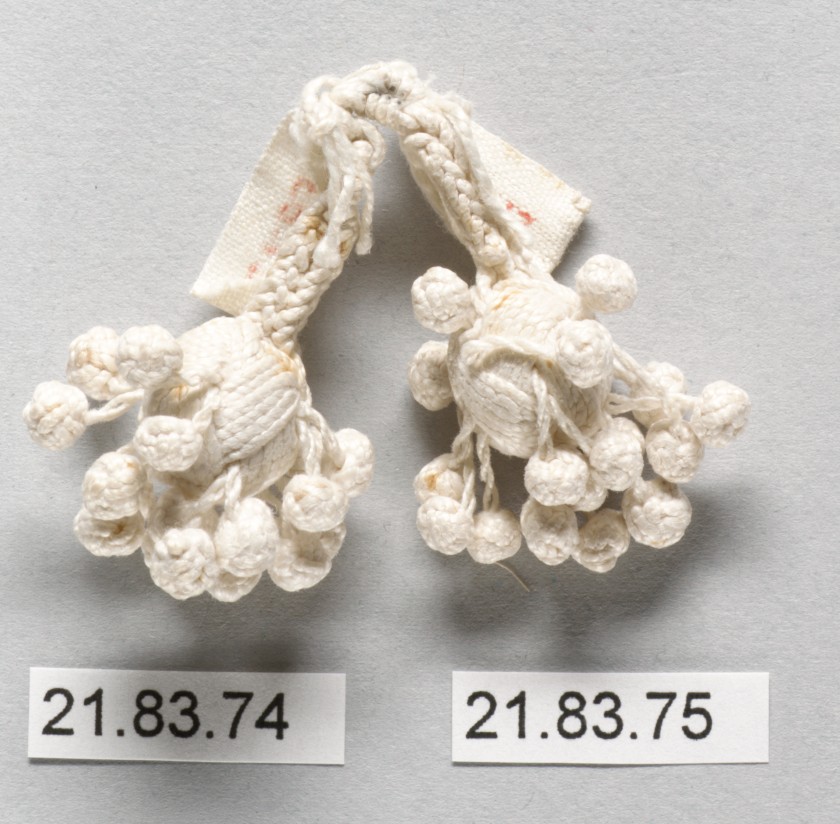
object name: tassel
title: Pair of tassels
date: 1601-1700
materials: linen